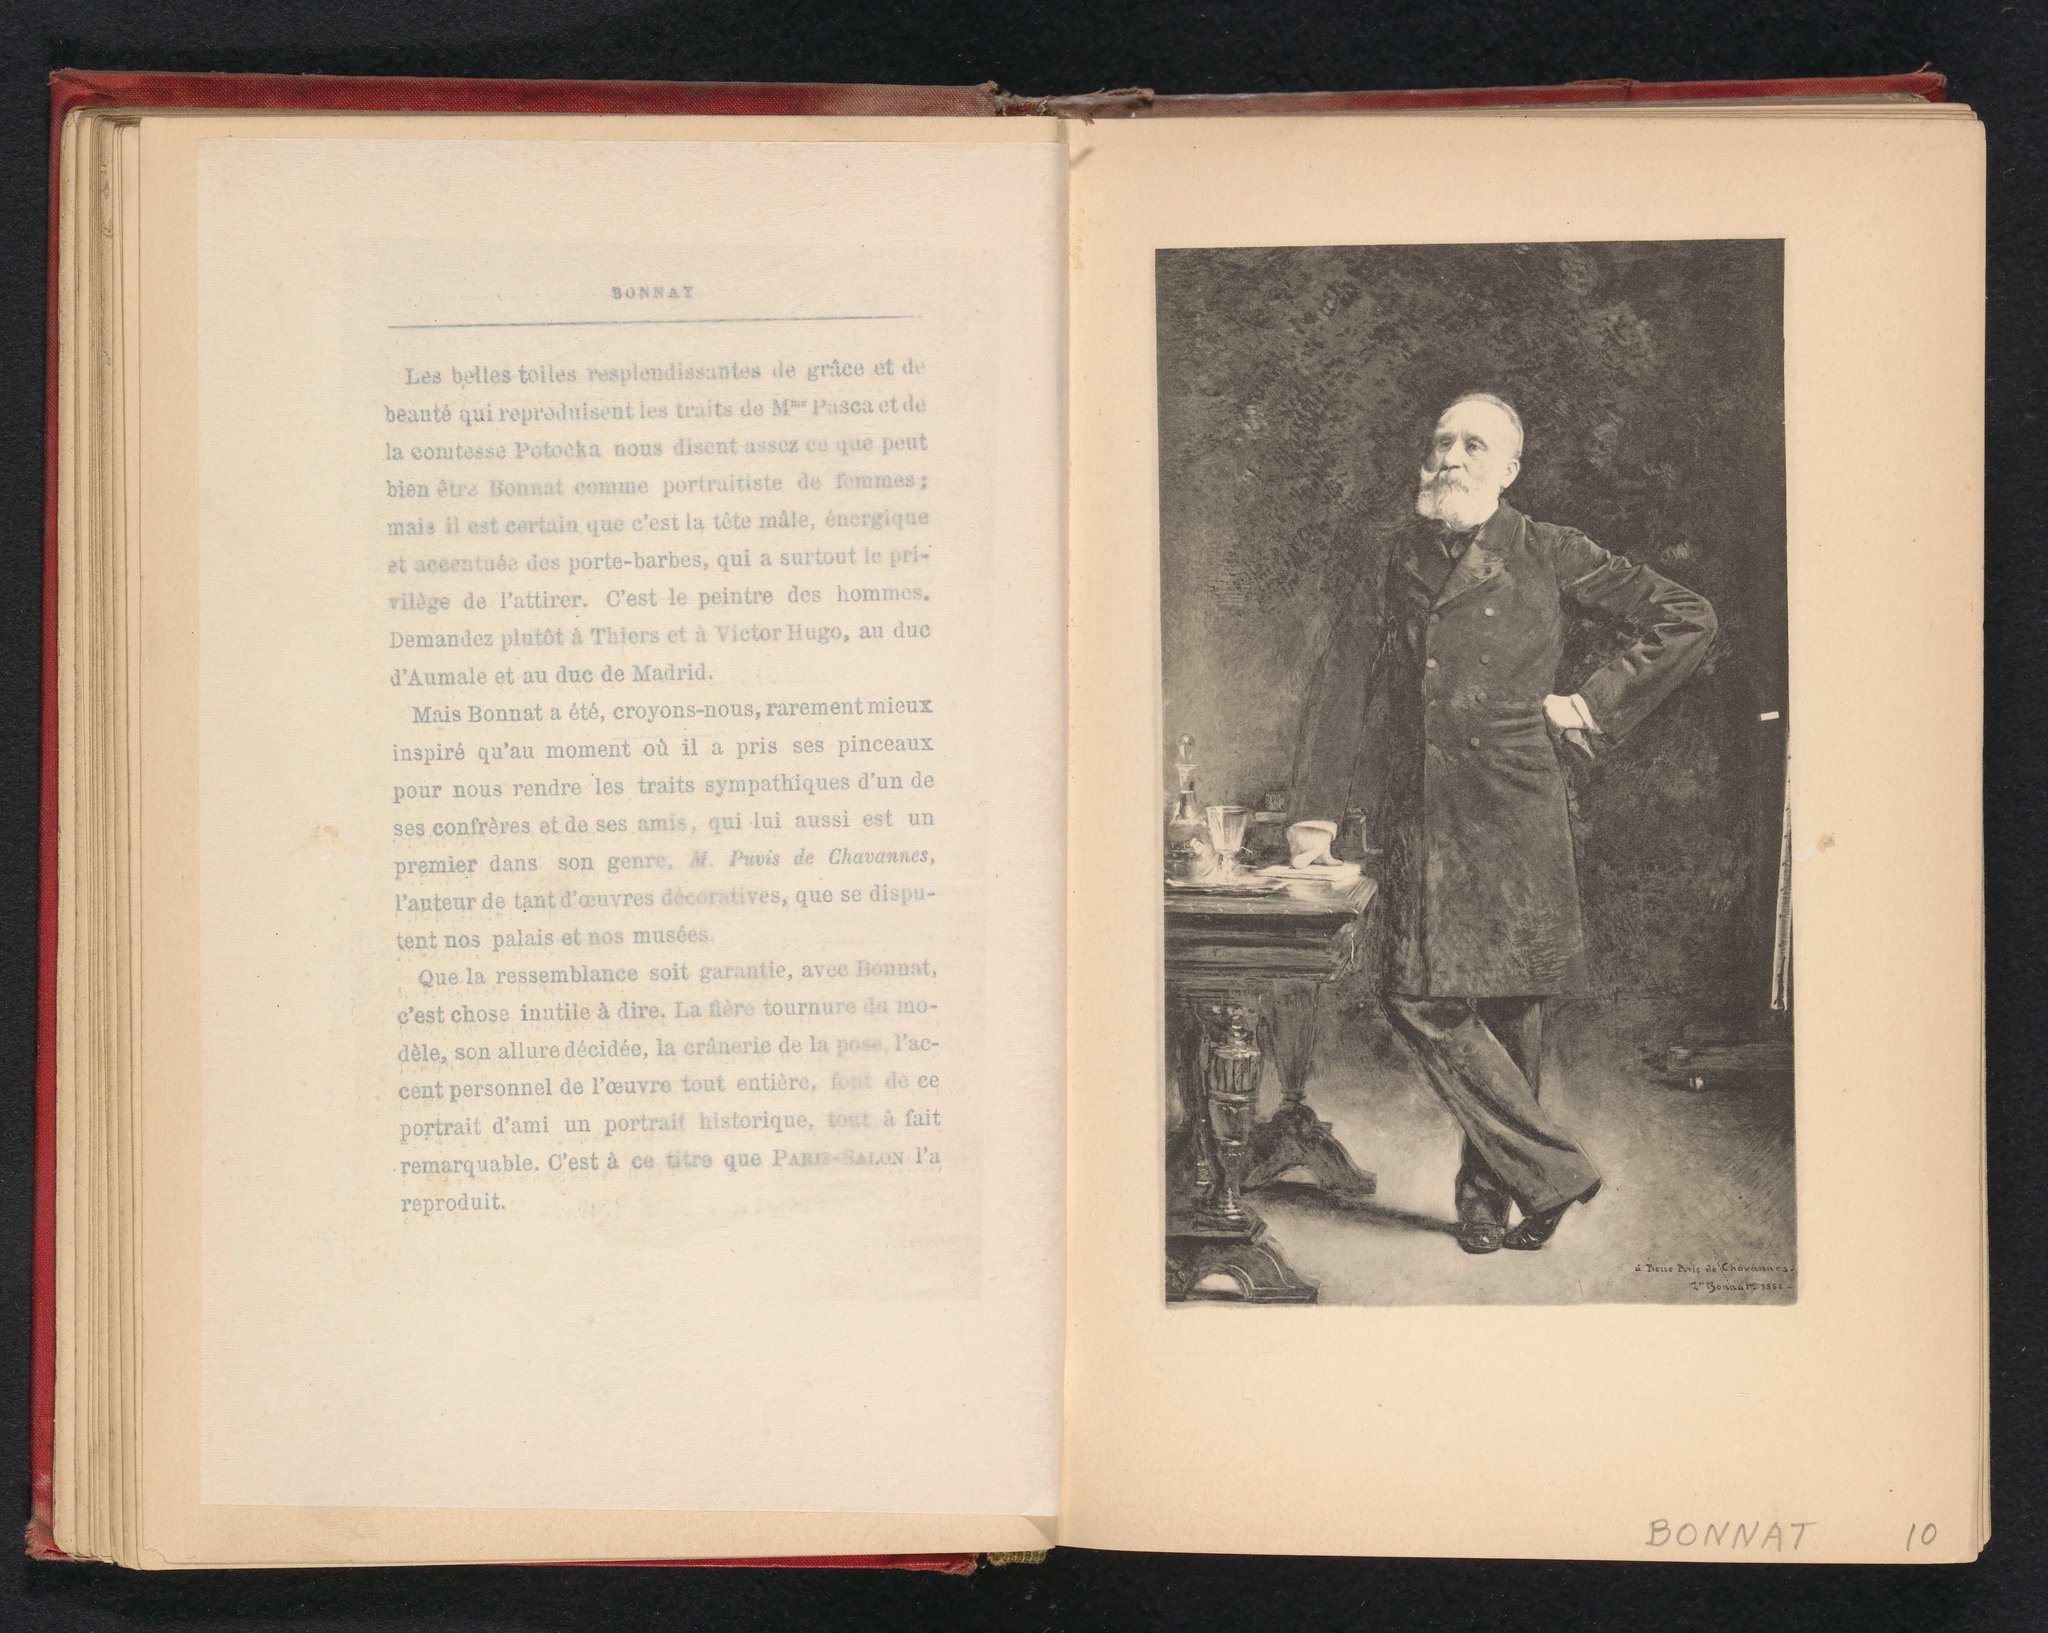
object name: page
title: Fotoreproductie van een schilderij, voorstellende een portret van Pierre Puvis de Chavannes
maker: léon bonnat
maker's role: painter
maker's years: 1833-1922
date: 1872-1882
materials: paper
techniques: photograph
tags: lyon, paris, print maker, draughtsman, pierre cécile puvis de chavannes, portrait, self-portrait of painter